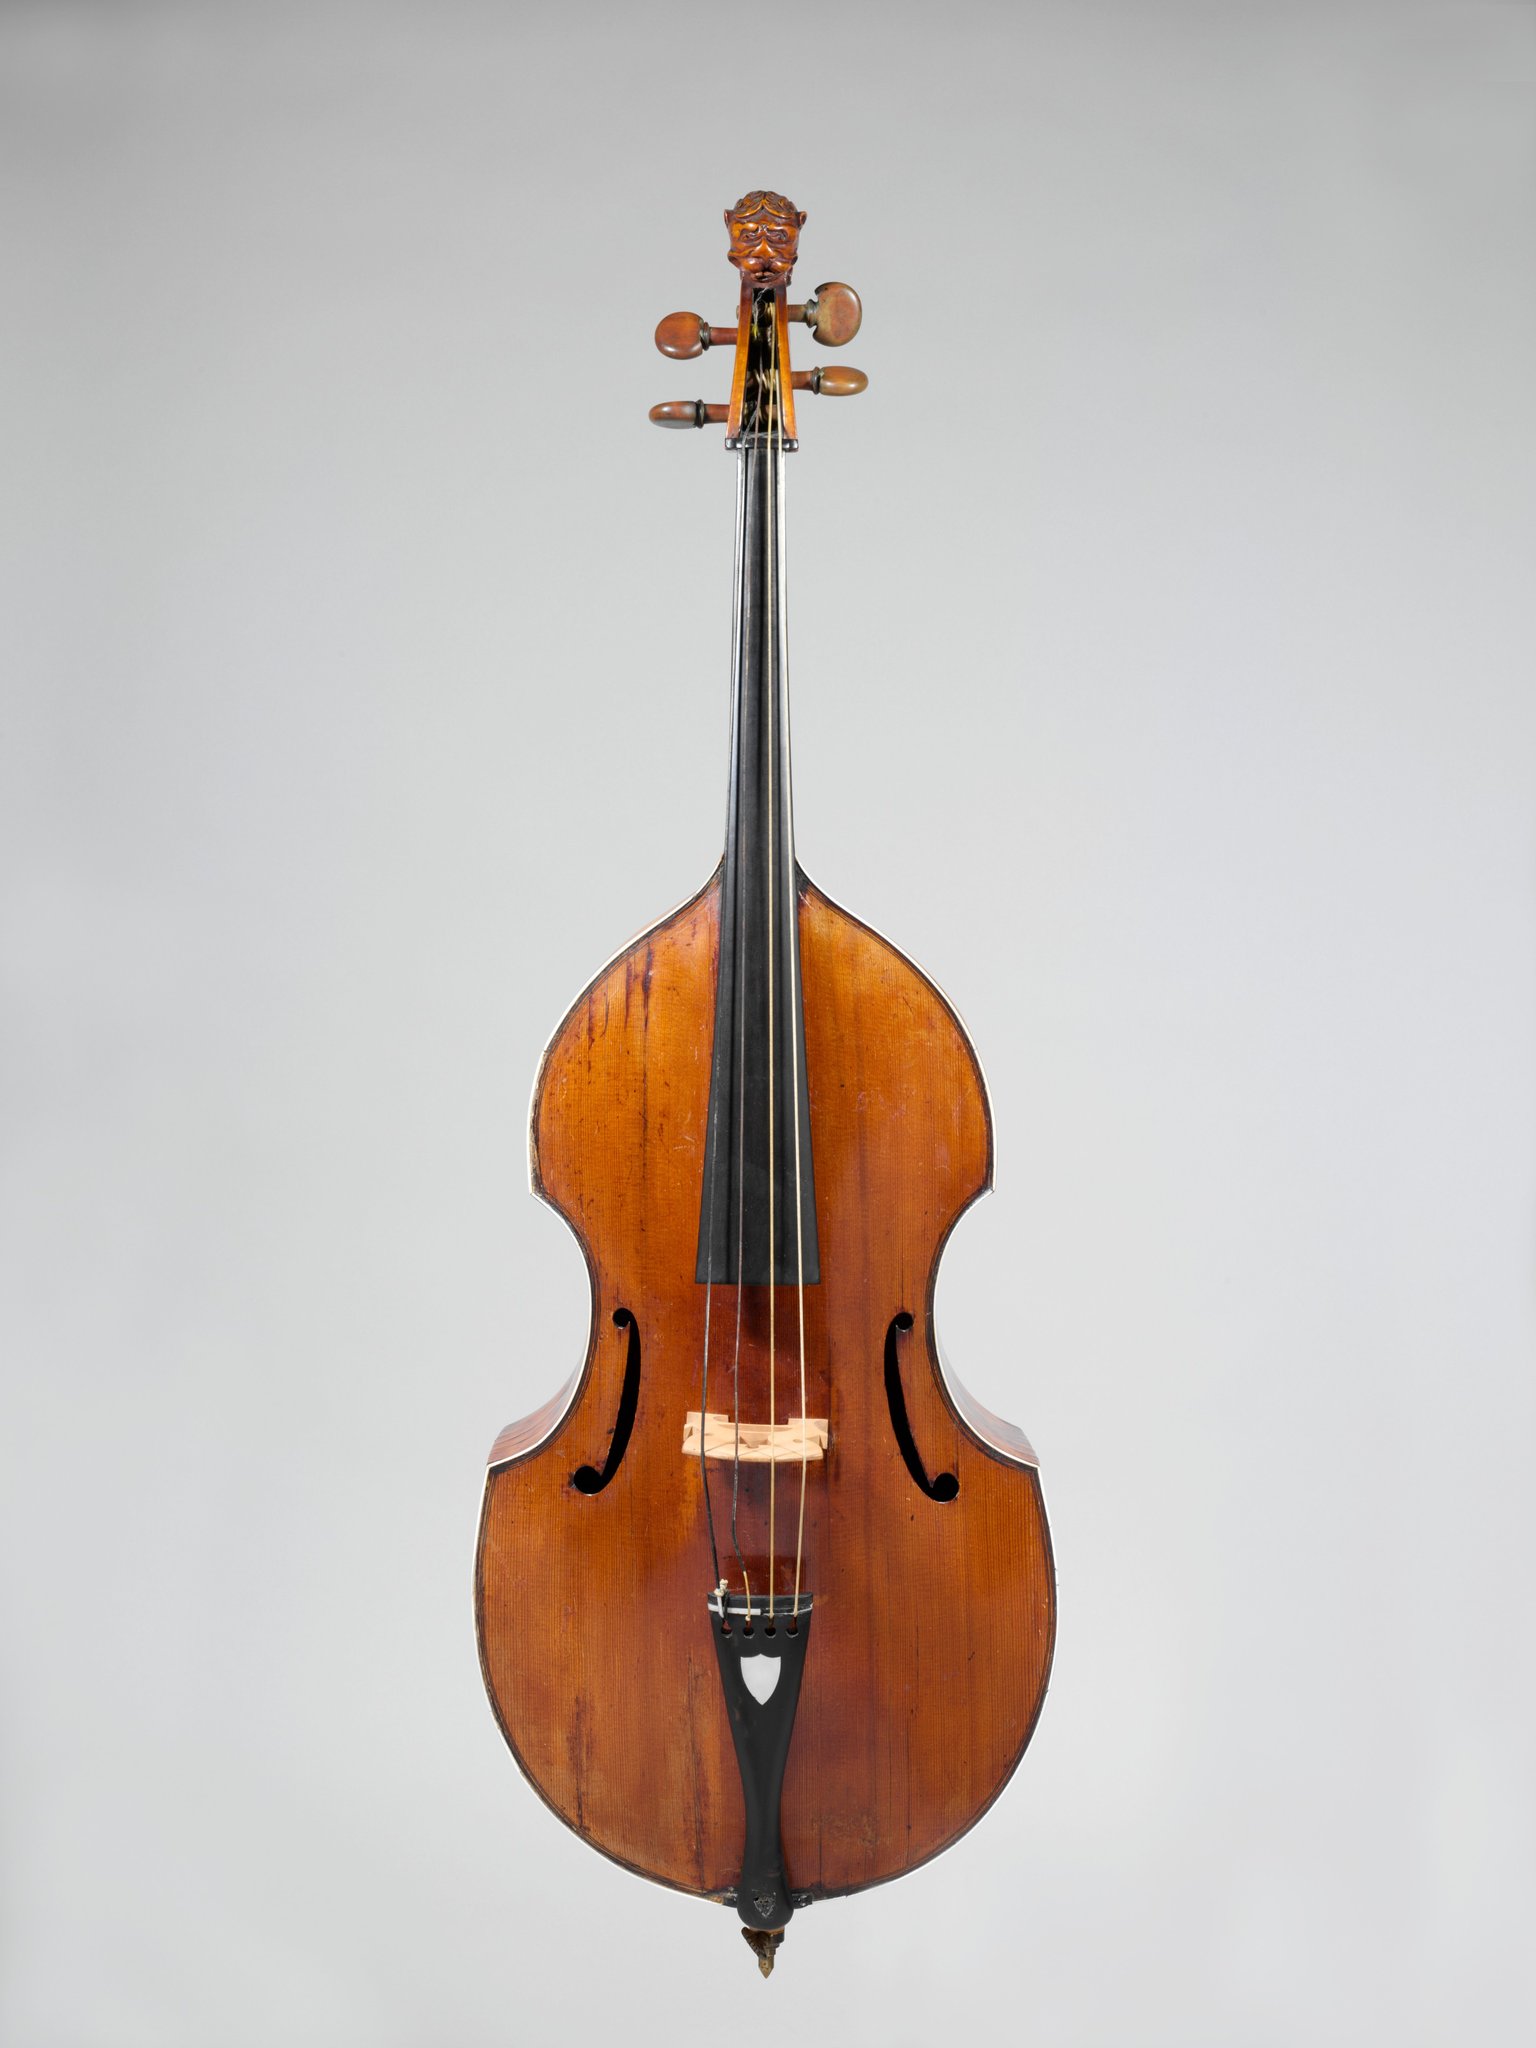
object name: division viol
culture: german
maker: school of tielke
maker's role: maker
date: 1720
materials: ivory, shell, wood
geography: germany